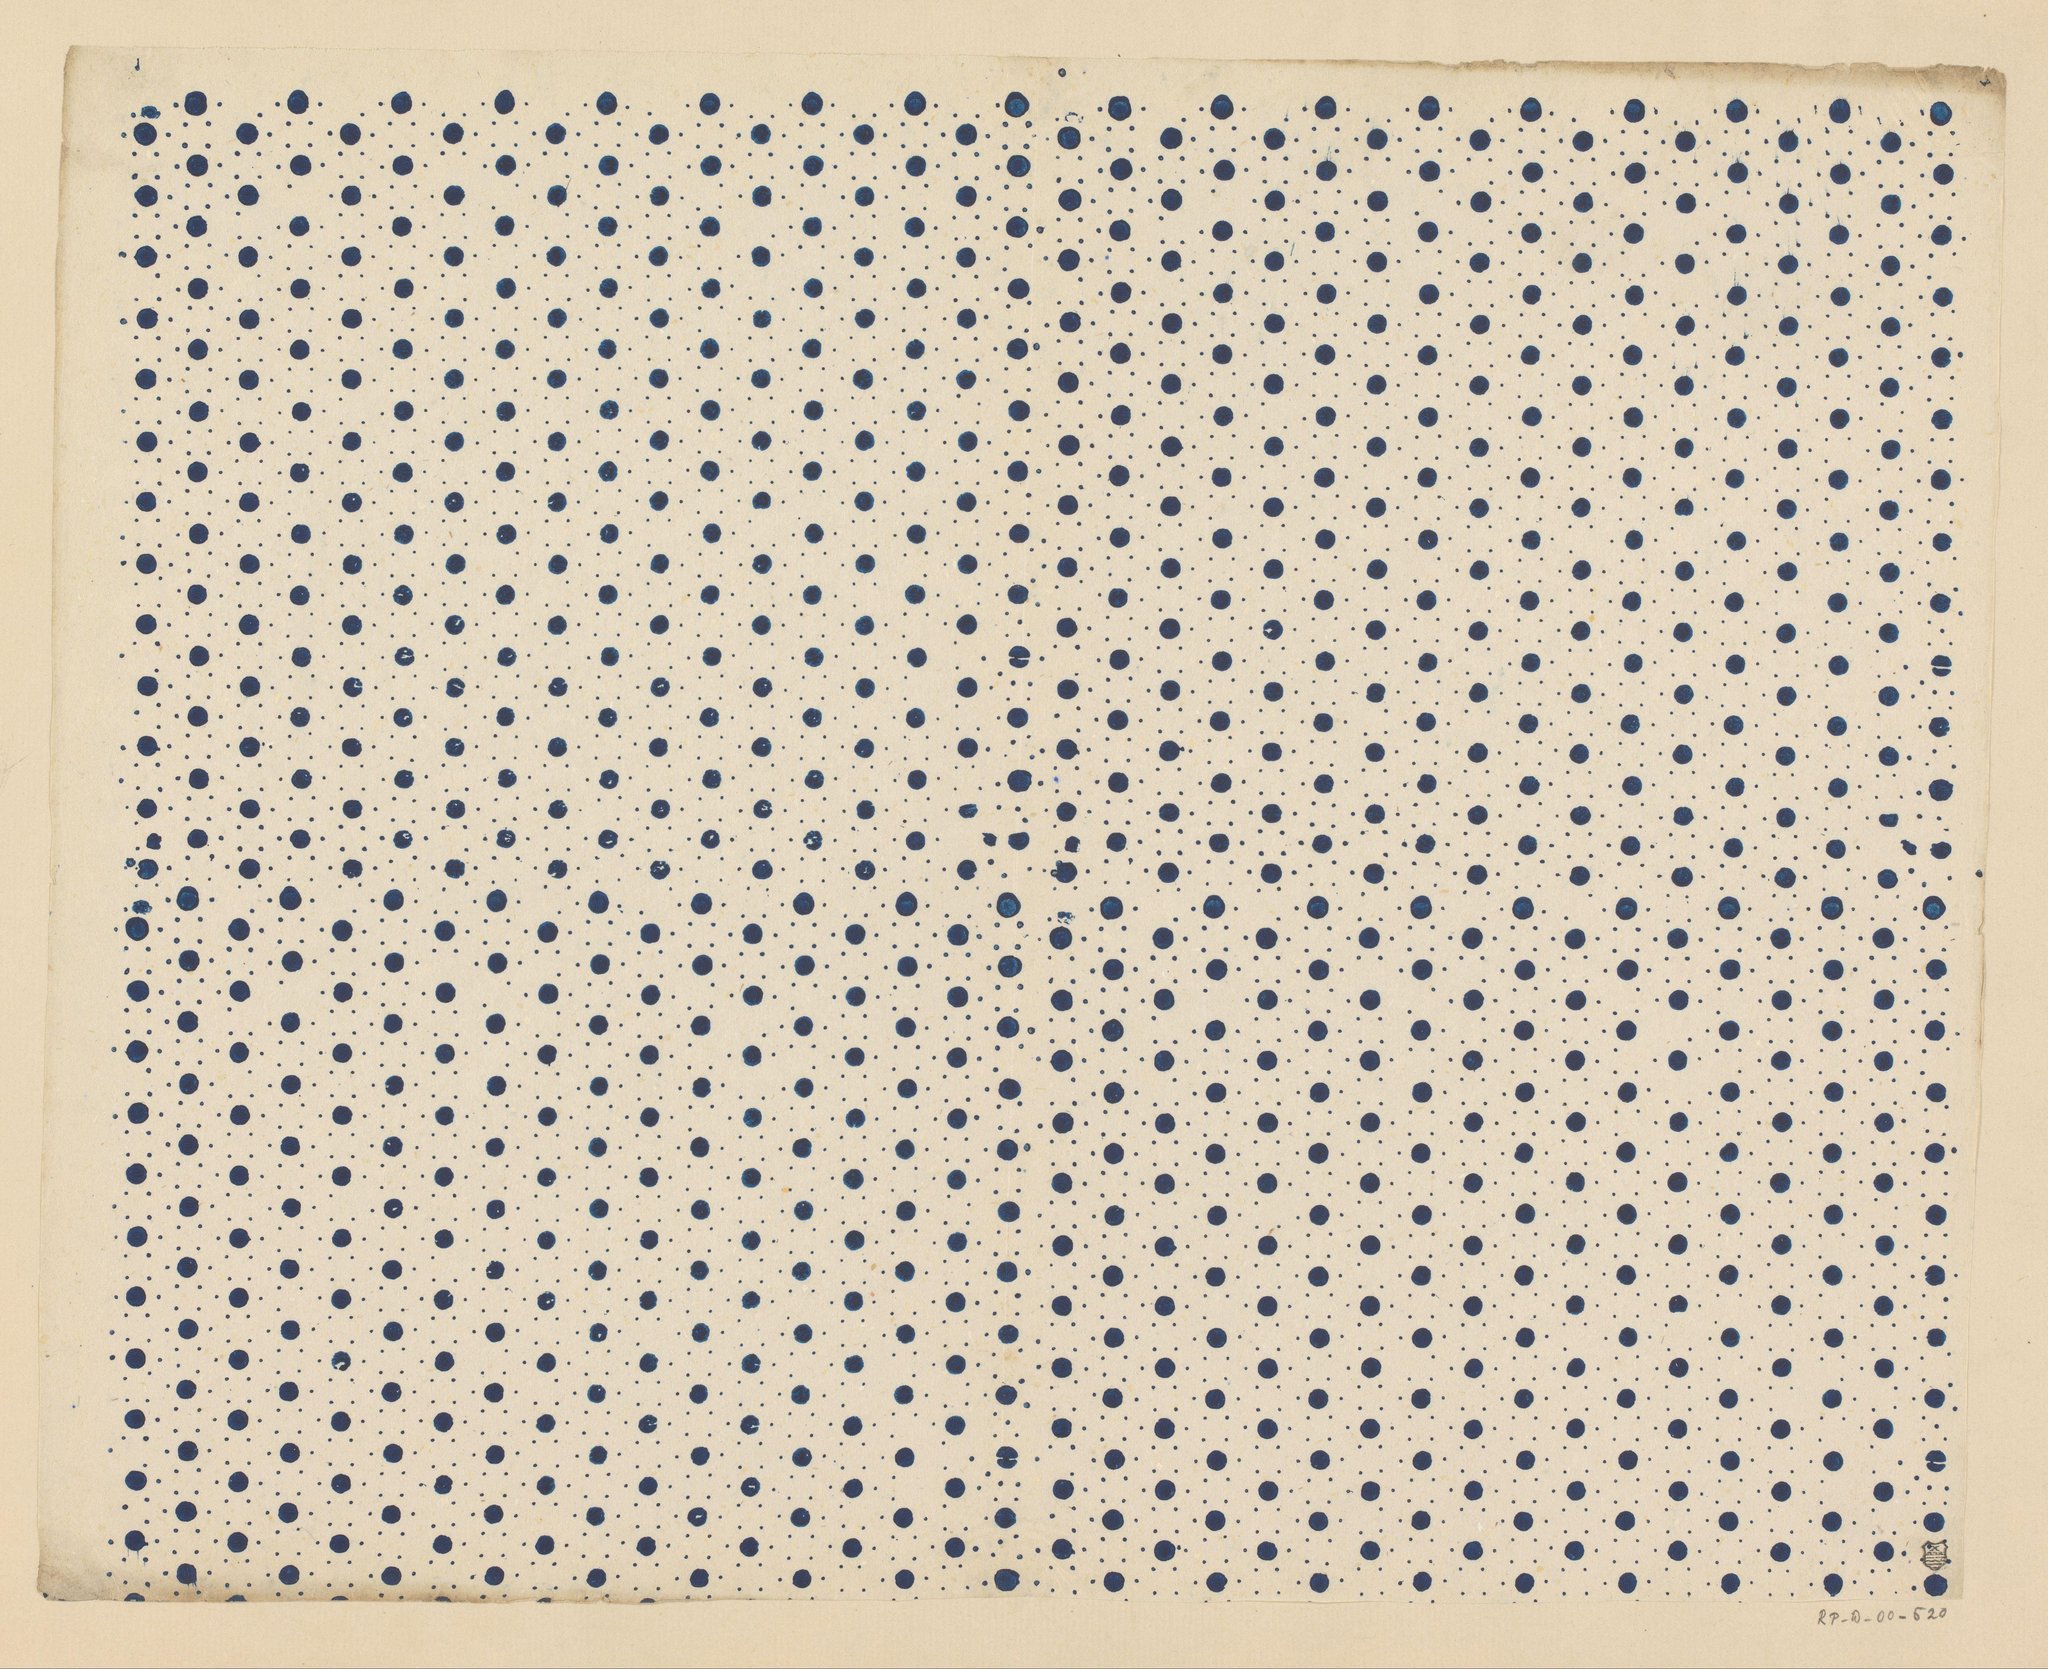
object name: printed paper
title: Blad met strooipatroon van stippen en punten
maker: Anonymous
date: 1800-1900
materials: paper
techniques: printing block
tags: ornament ~ round and curved forms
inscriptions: collector's mark: Lugt 2760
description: Blad met strooipatroon van stippen en punten.